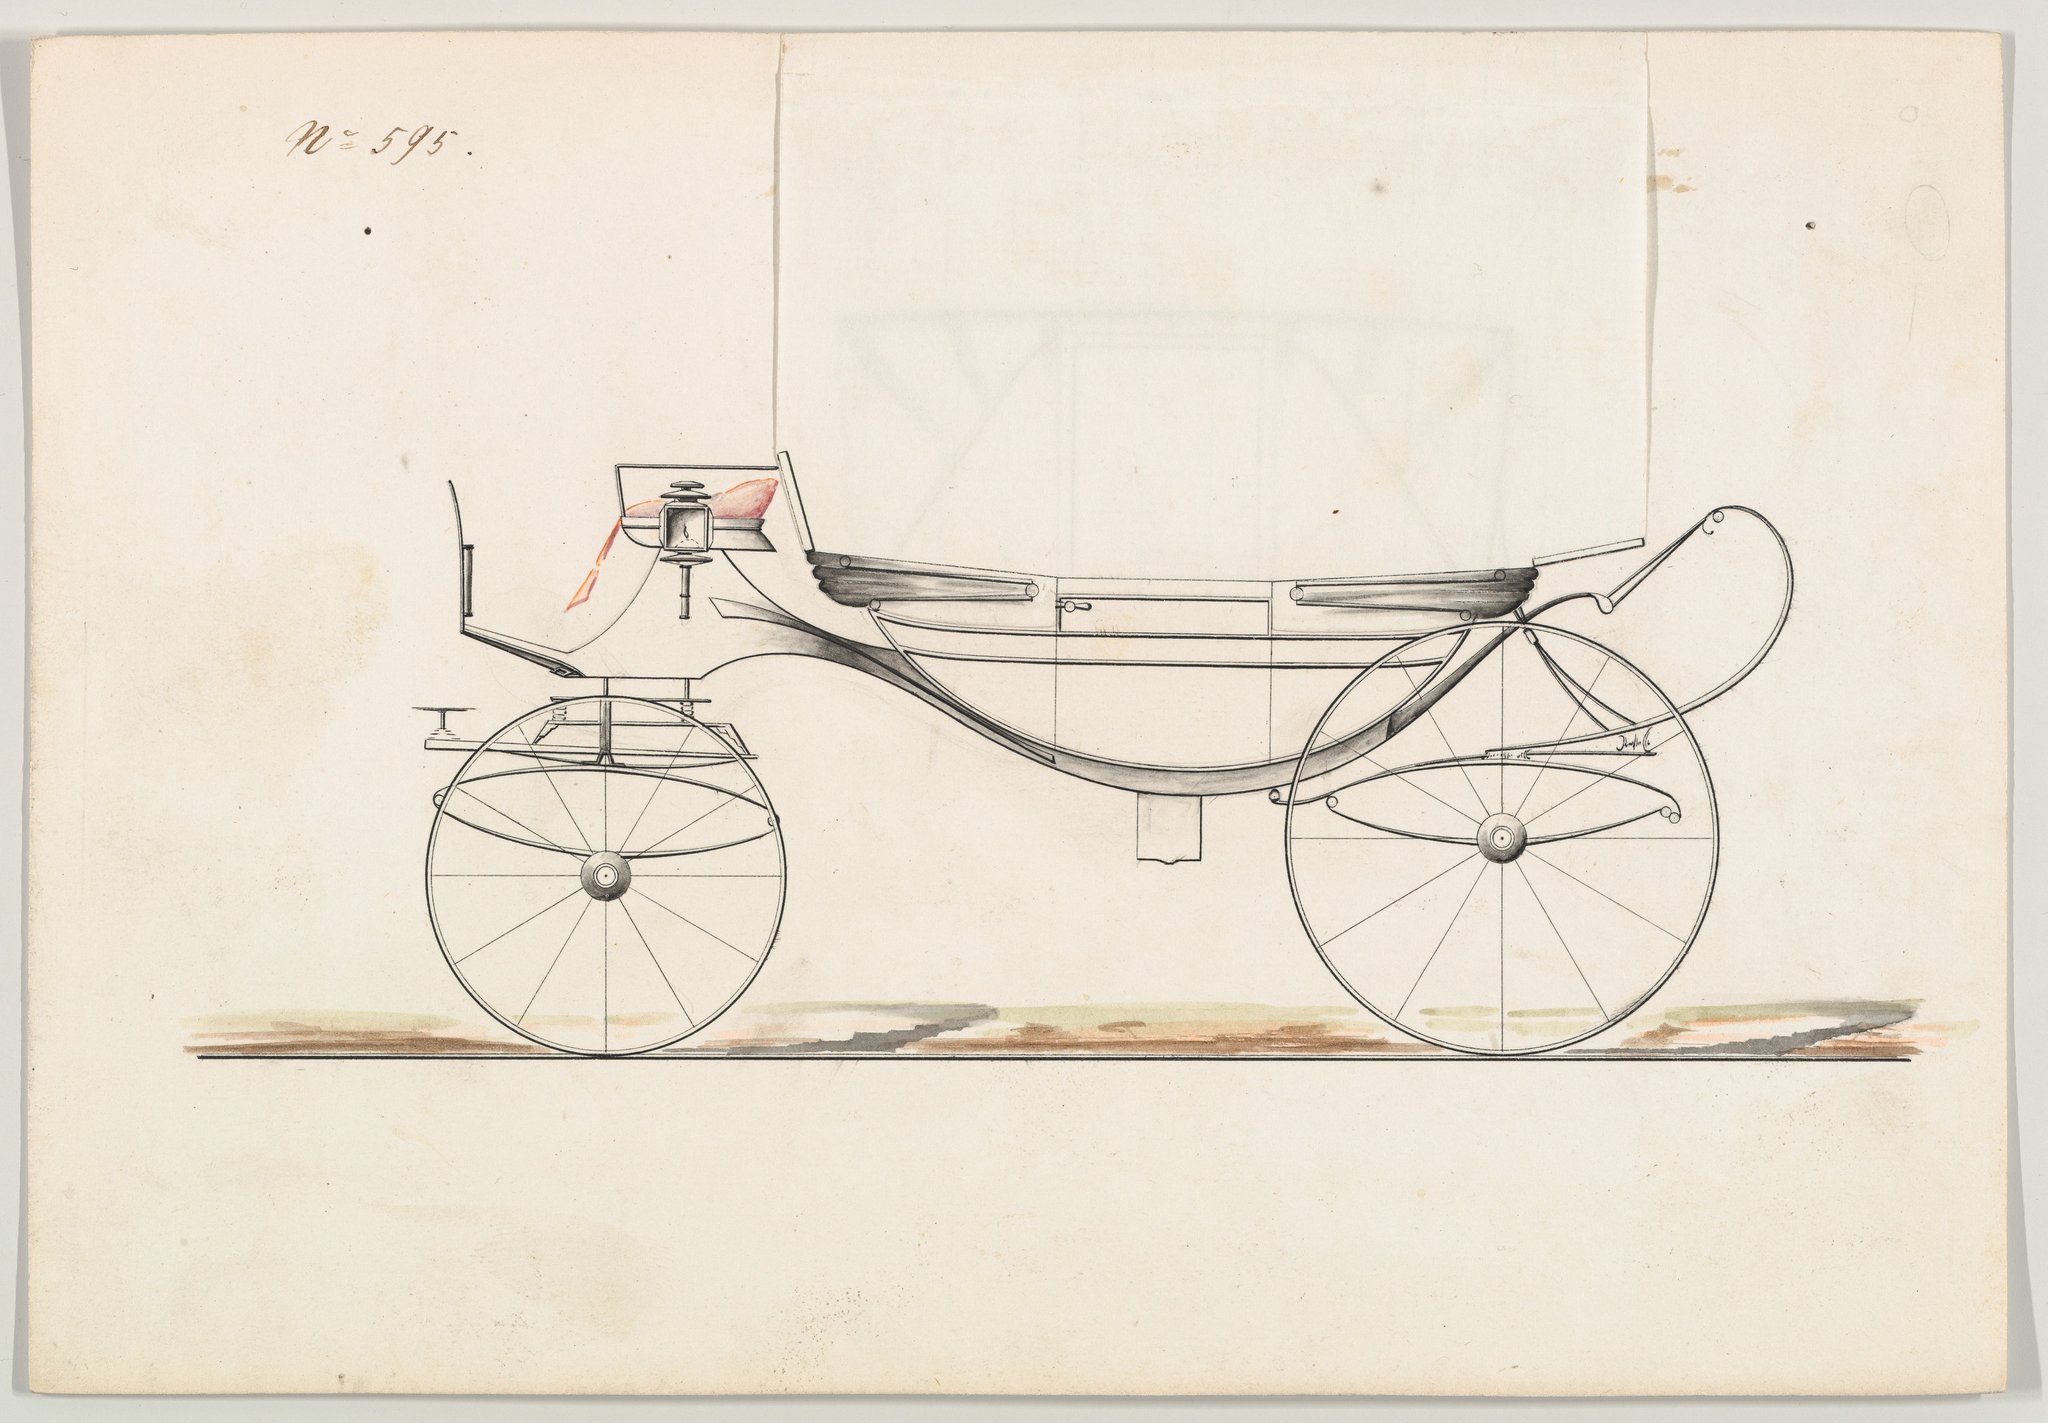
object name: drawing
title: Landau #595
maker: brewster & co.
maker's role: manufacturer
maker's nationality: american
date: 1850-1870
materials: gouache, ink, watercolor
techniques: pen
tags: carriages